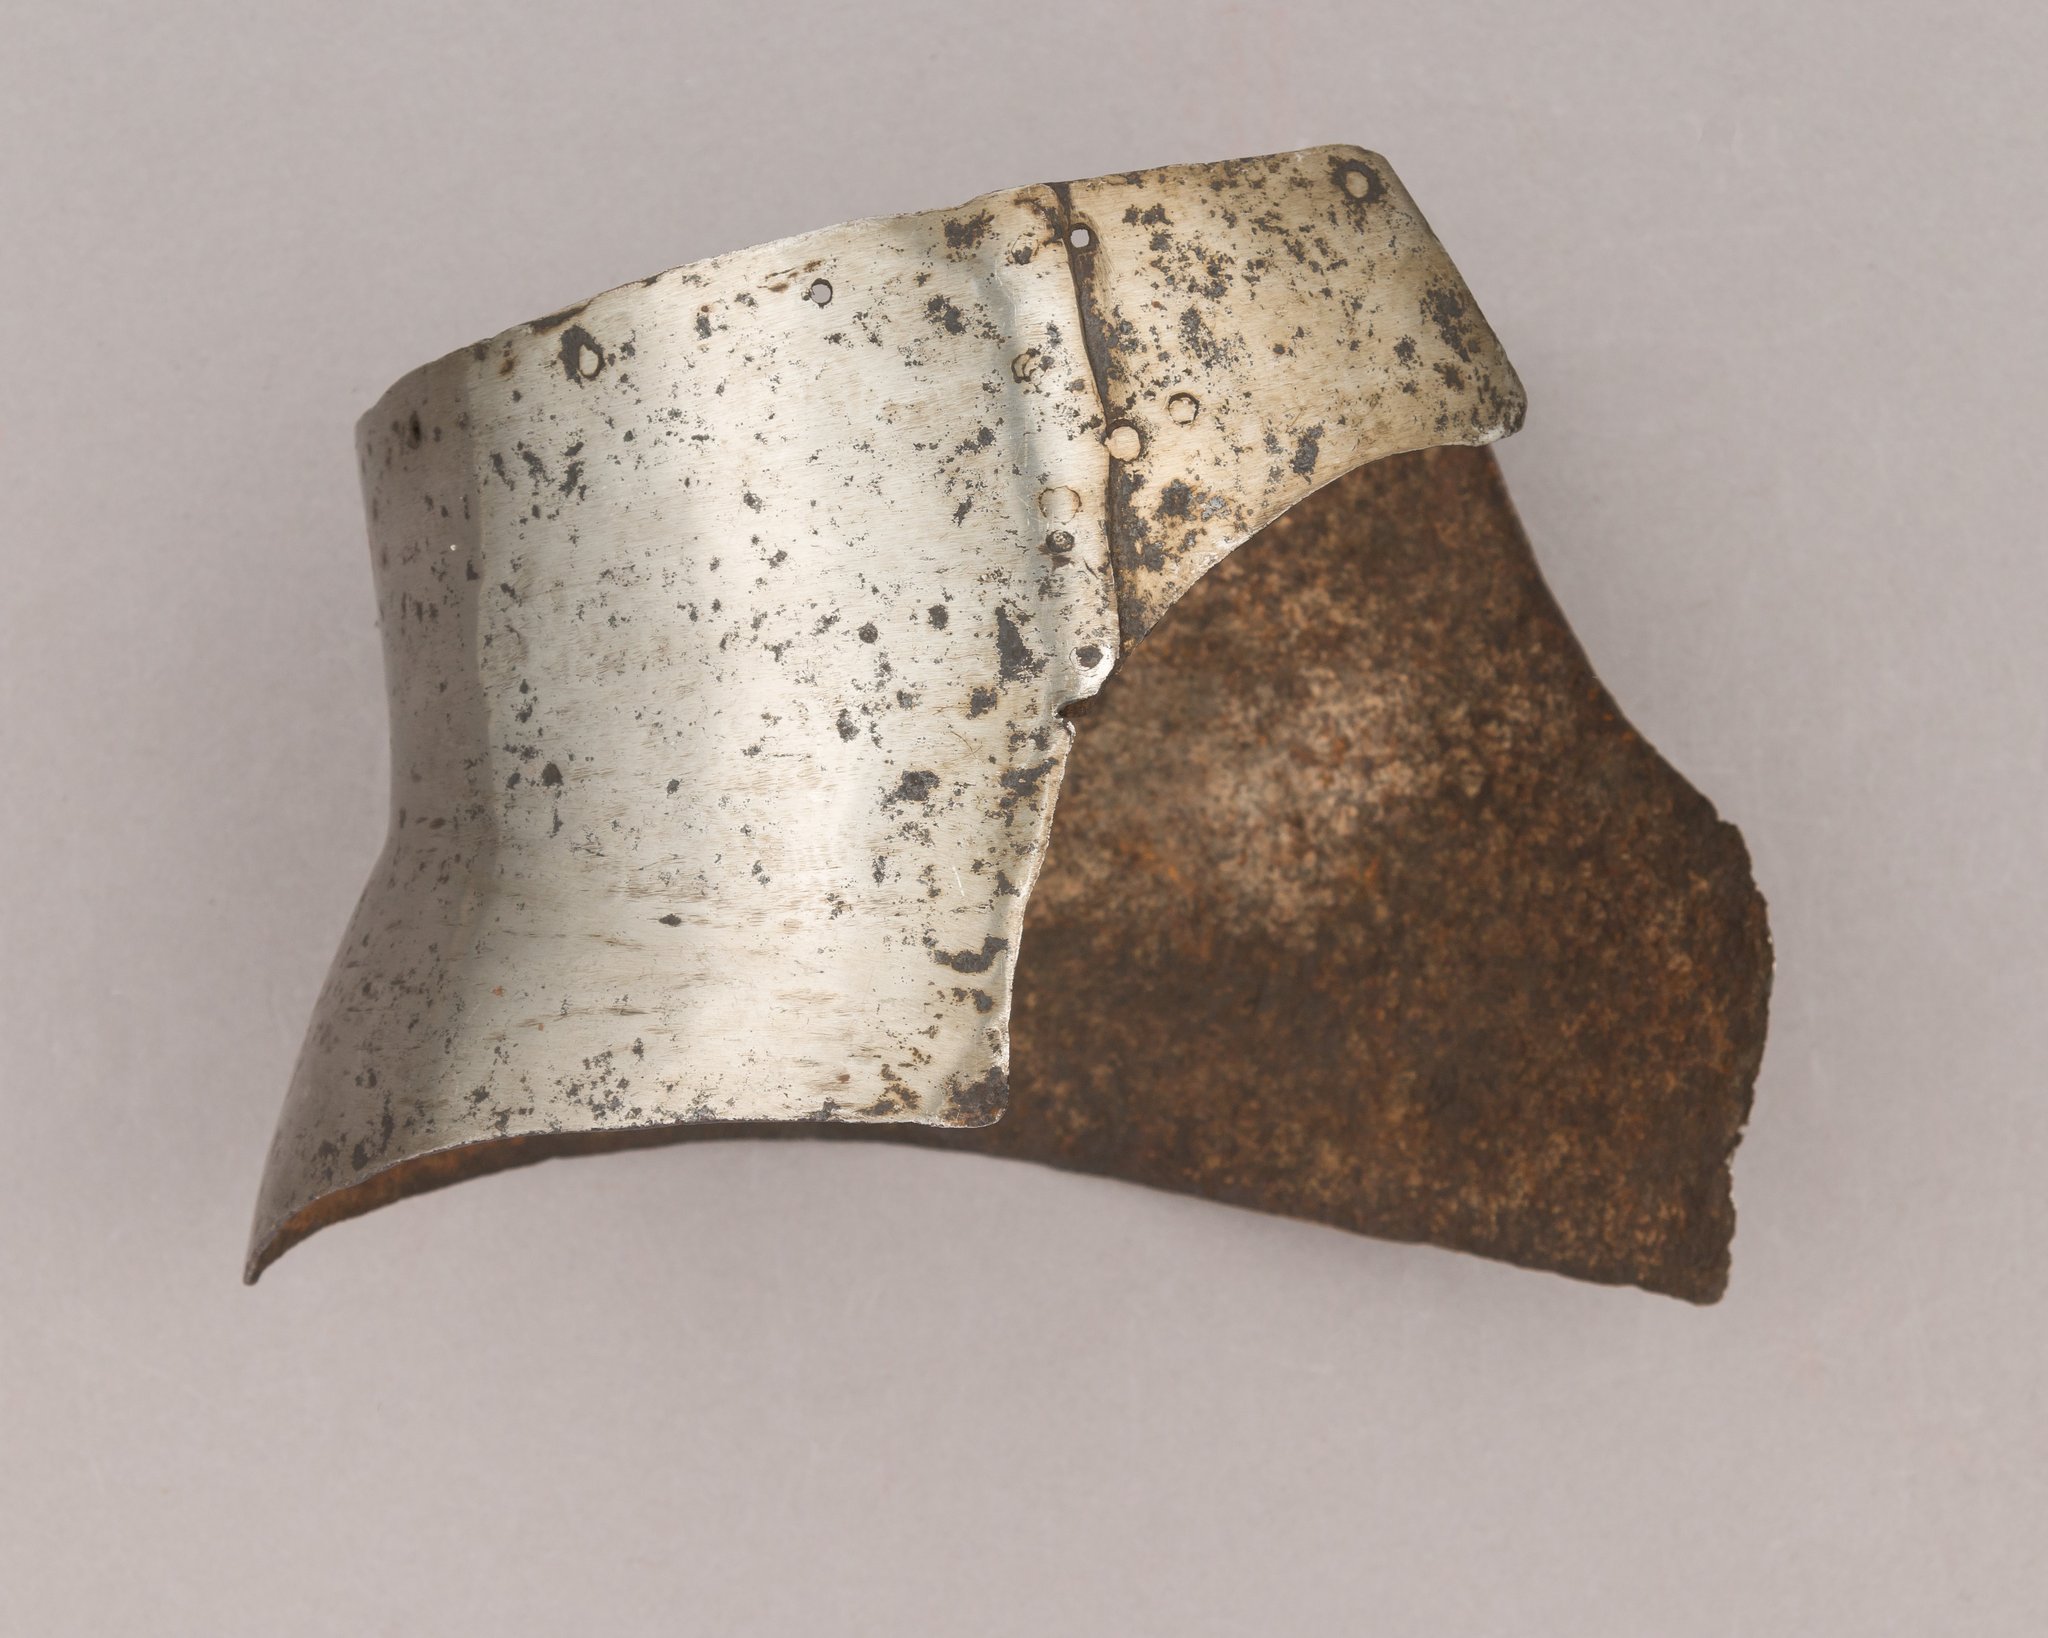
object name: lower plate of a bascinet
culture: italian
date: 1401-1433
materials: iron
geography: italy